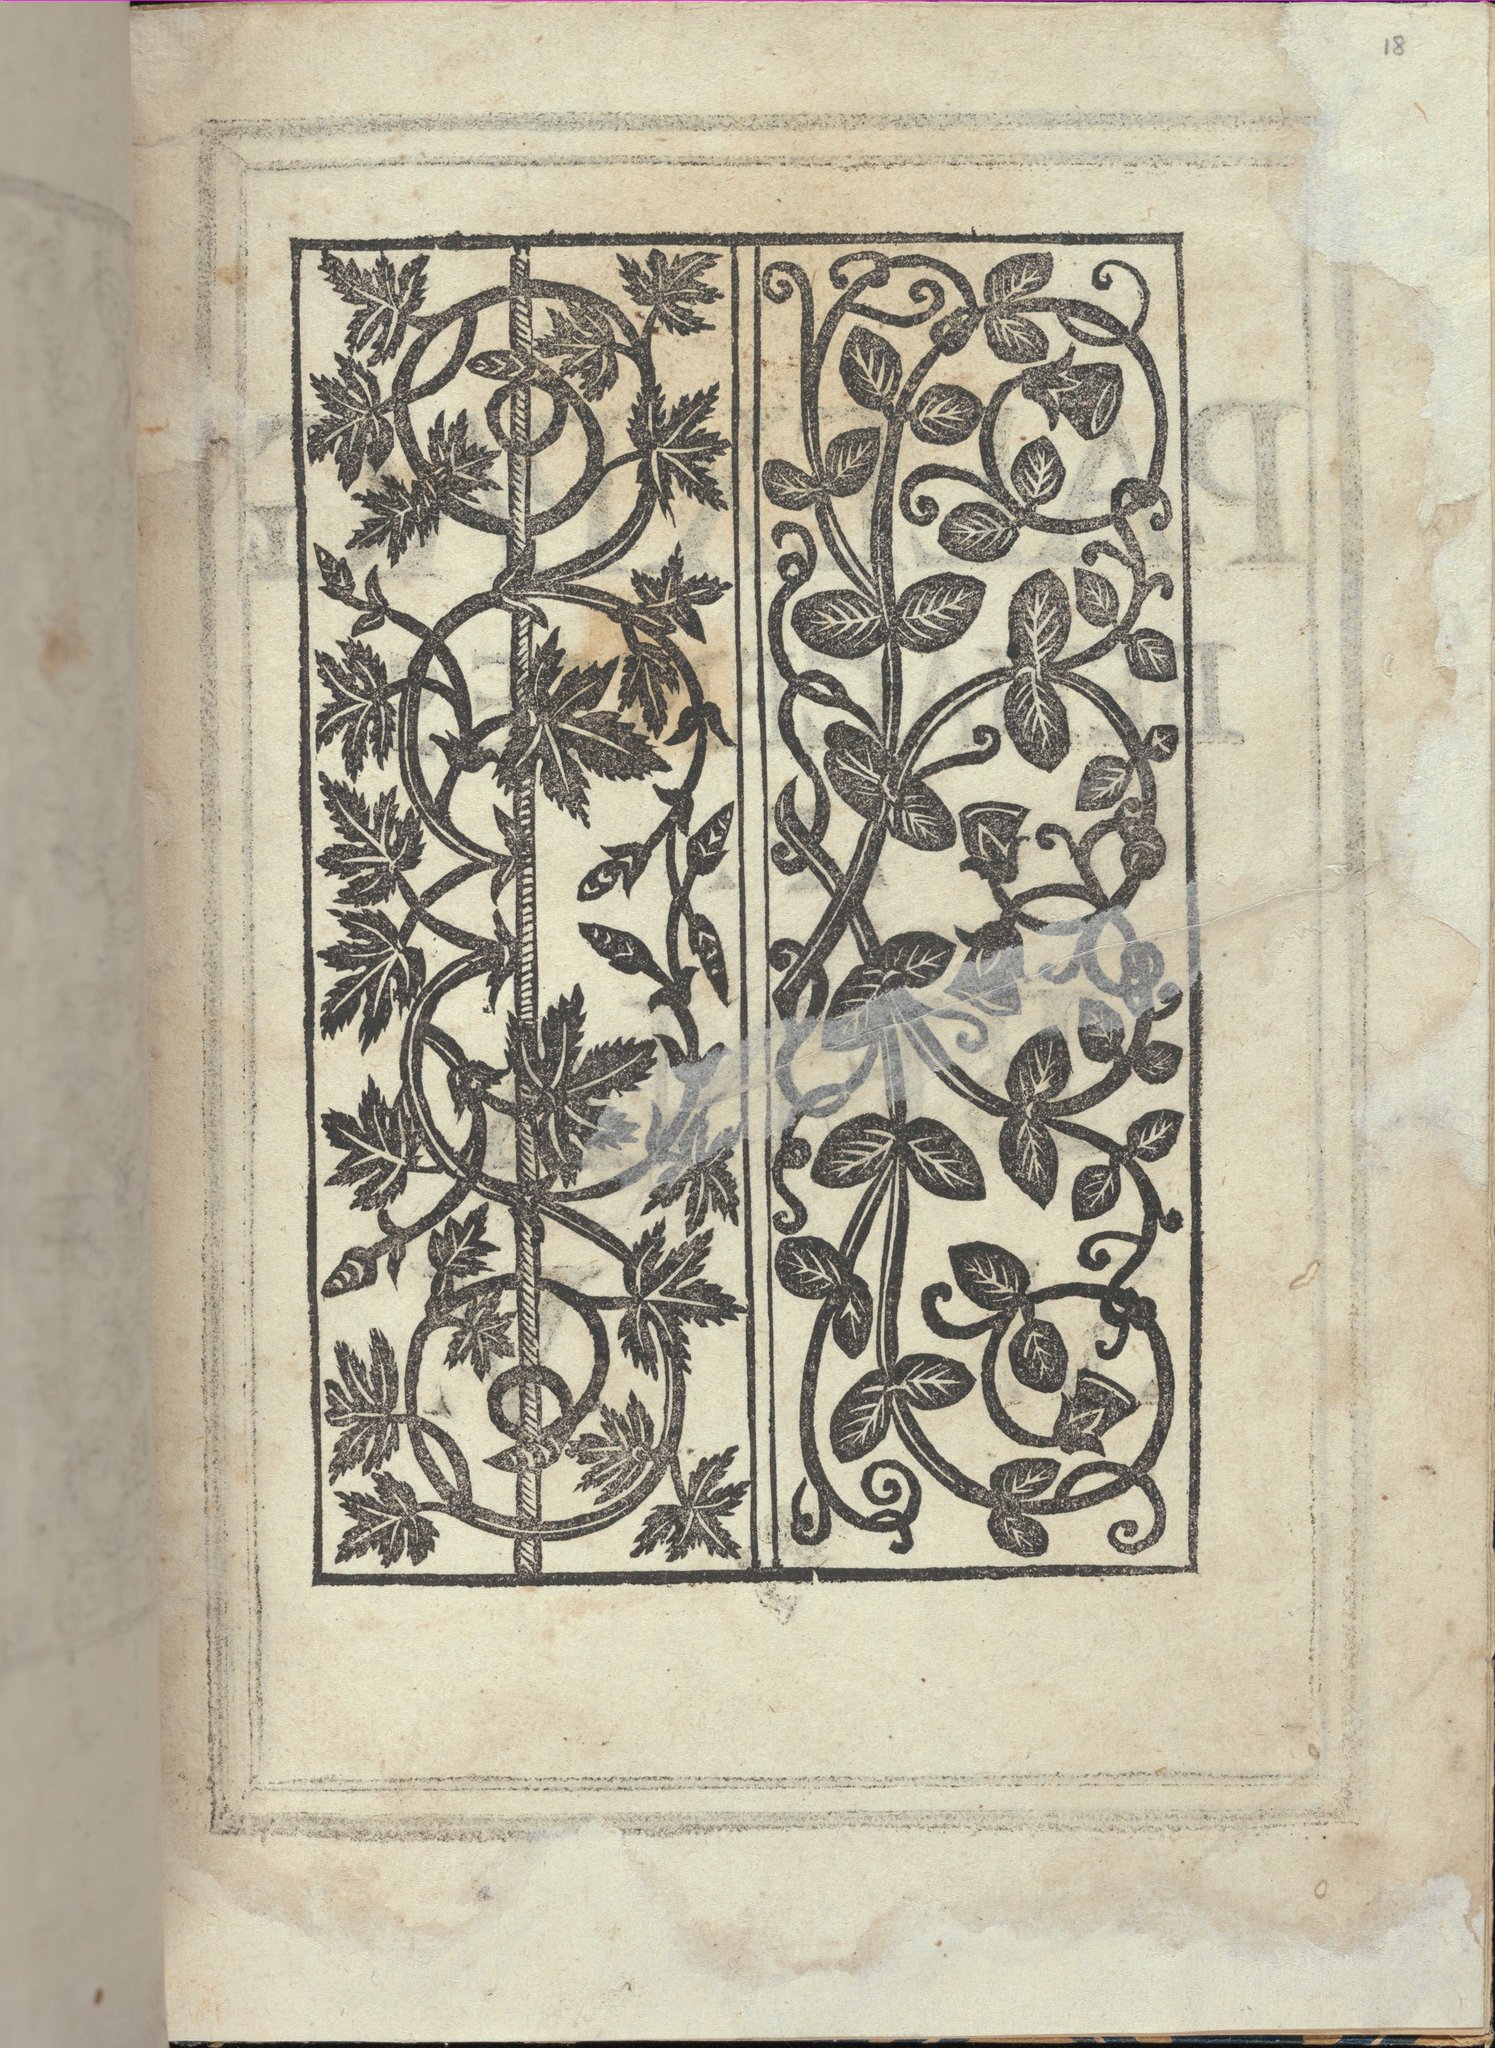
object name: book print ornament architecture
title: Libro quarto. De rechami per elquale se impara in diuersi modi lordine e il modo de recamare...Opera noua, page 18 (recto)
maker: alessandro paganino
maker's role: publisher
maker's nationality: italian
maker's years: 1500-1550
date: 1532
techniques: woodcut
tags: vines